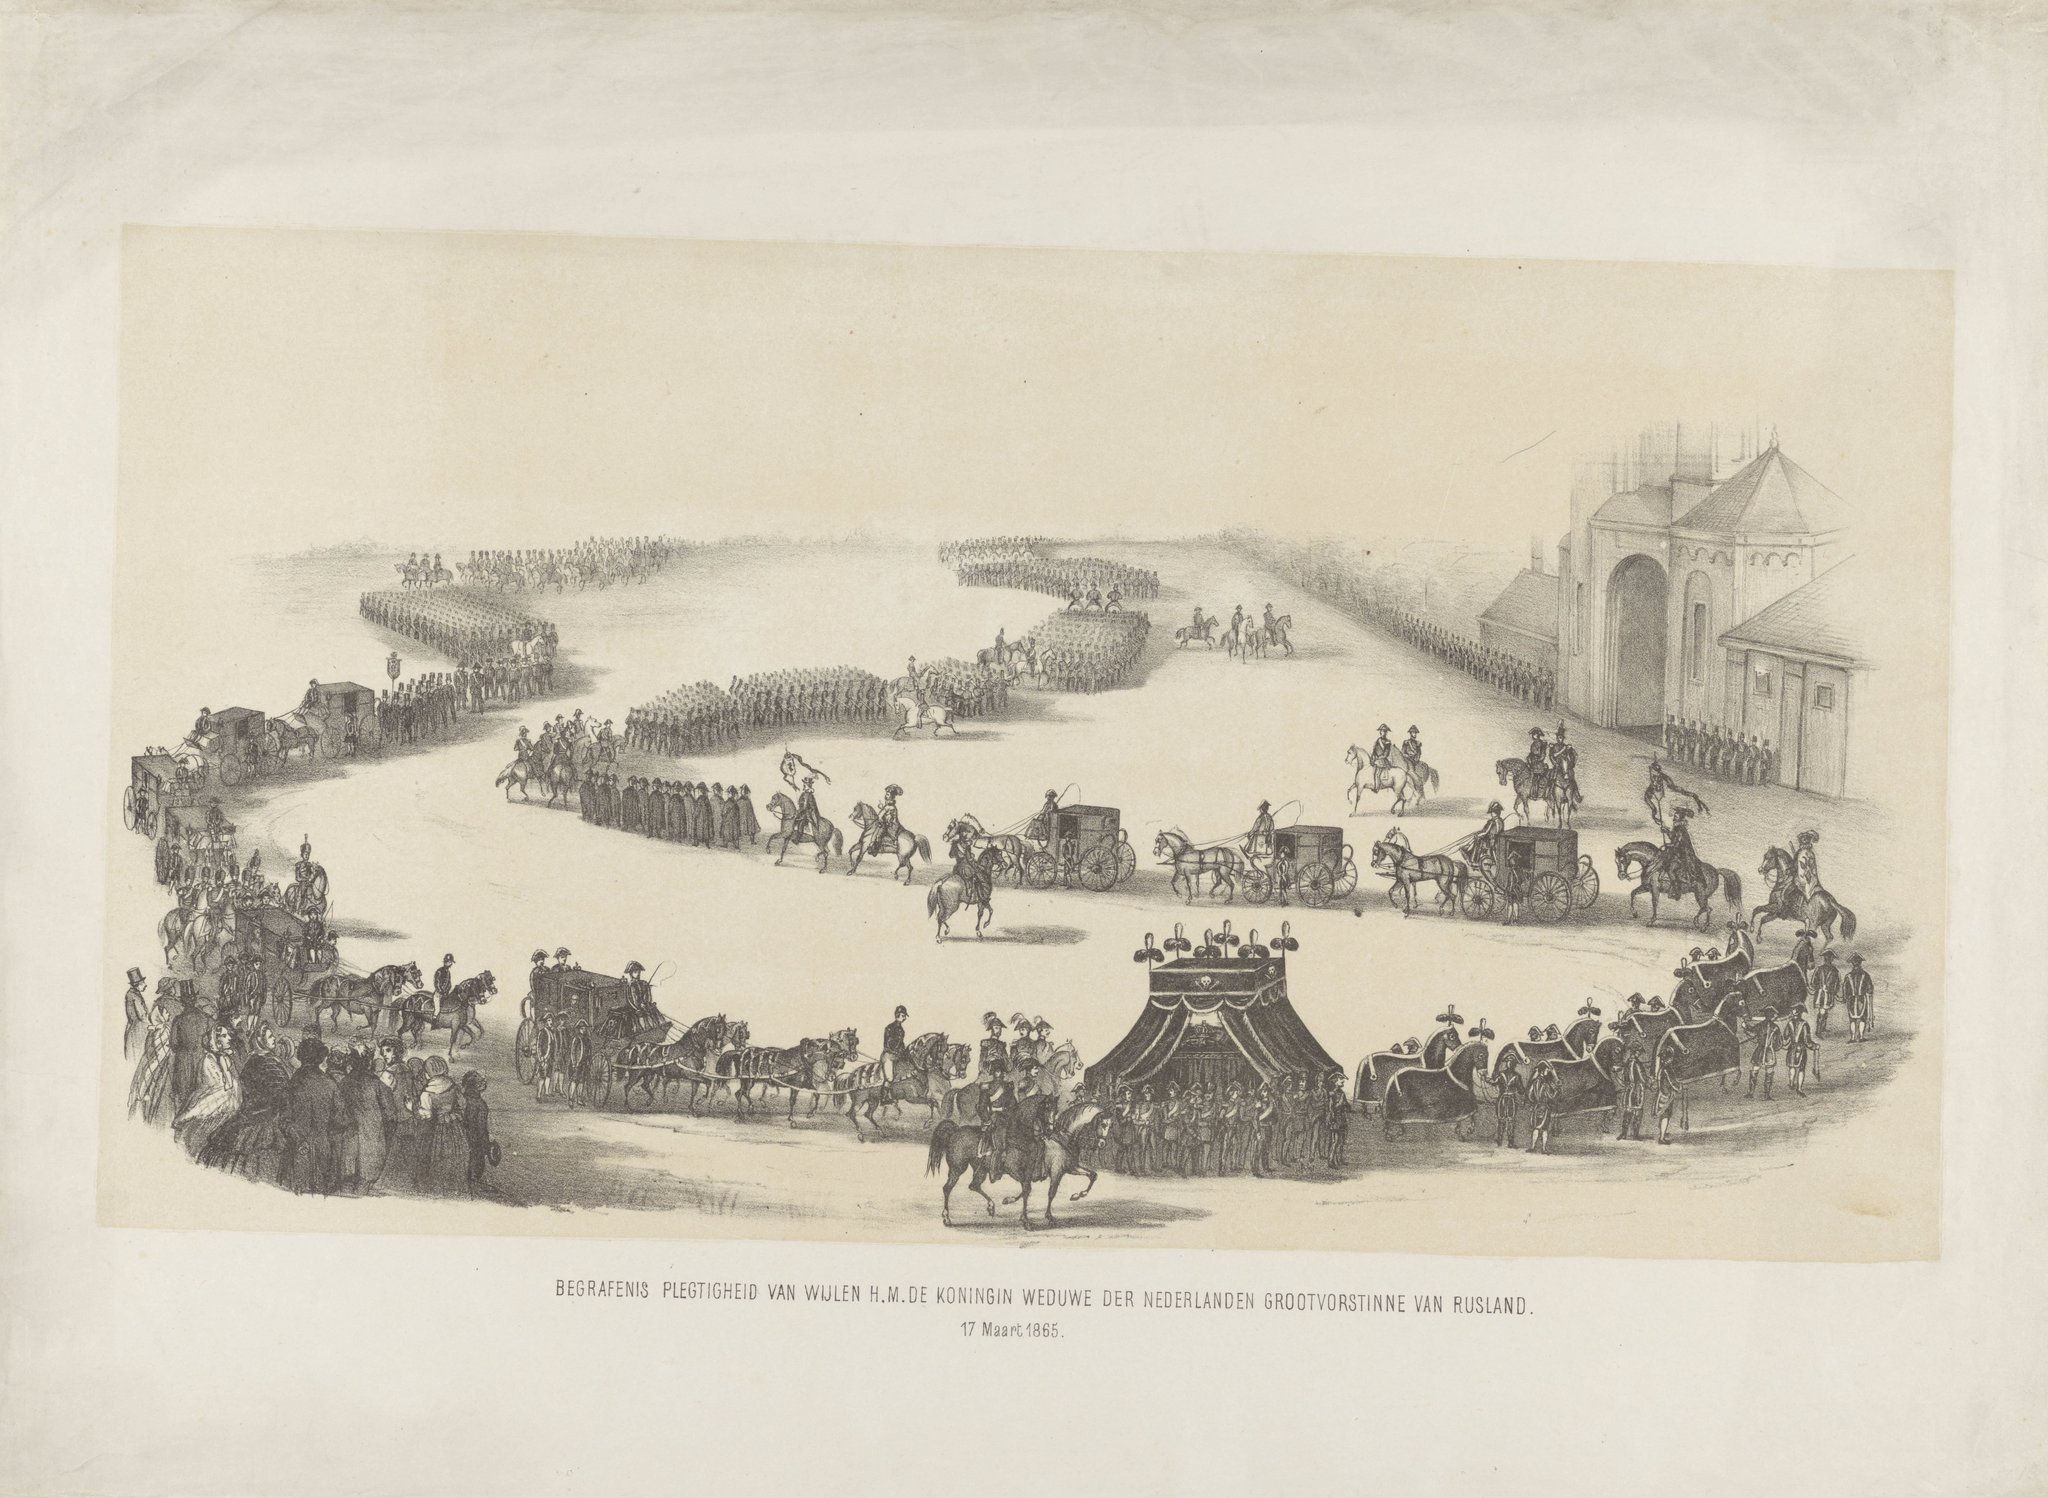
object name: print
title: Begrafenis plegtigheid van wijlen H.M. de koningin weduwe der Nederlanden grootvorstinne van Rusland. 17 Maart 1865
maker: Anonymous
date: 1865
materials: paper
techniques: tone lithography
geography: netherlands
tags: the hague, anna paulowna romanowa, cortege, funeral procession, delft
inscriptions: collector's mark: Lugt 2228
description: Begrafenisstoet van wijlen koningin Anna Paulowna te Delft op 17 maart 1865.